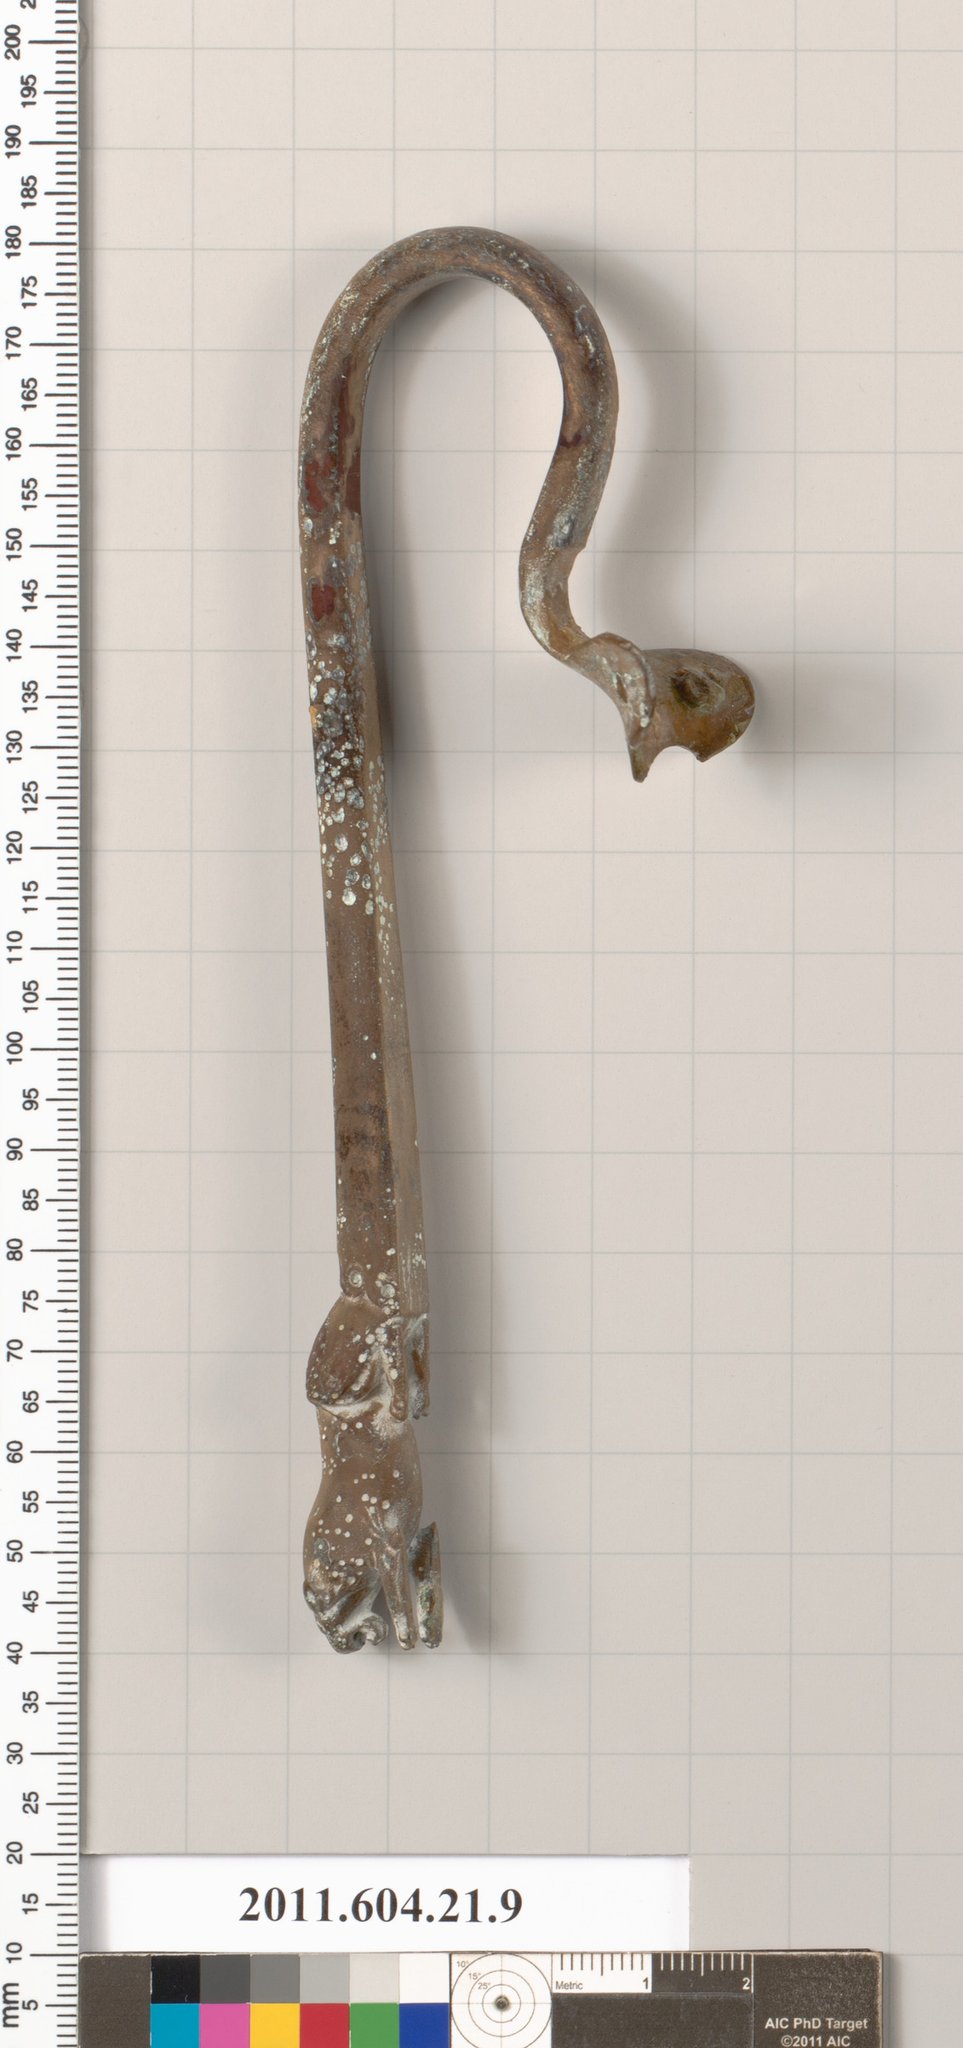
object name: bronze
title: Handle from a bronze olpe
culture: etruscan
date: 600-401 BCE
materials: bronze